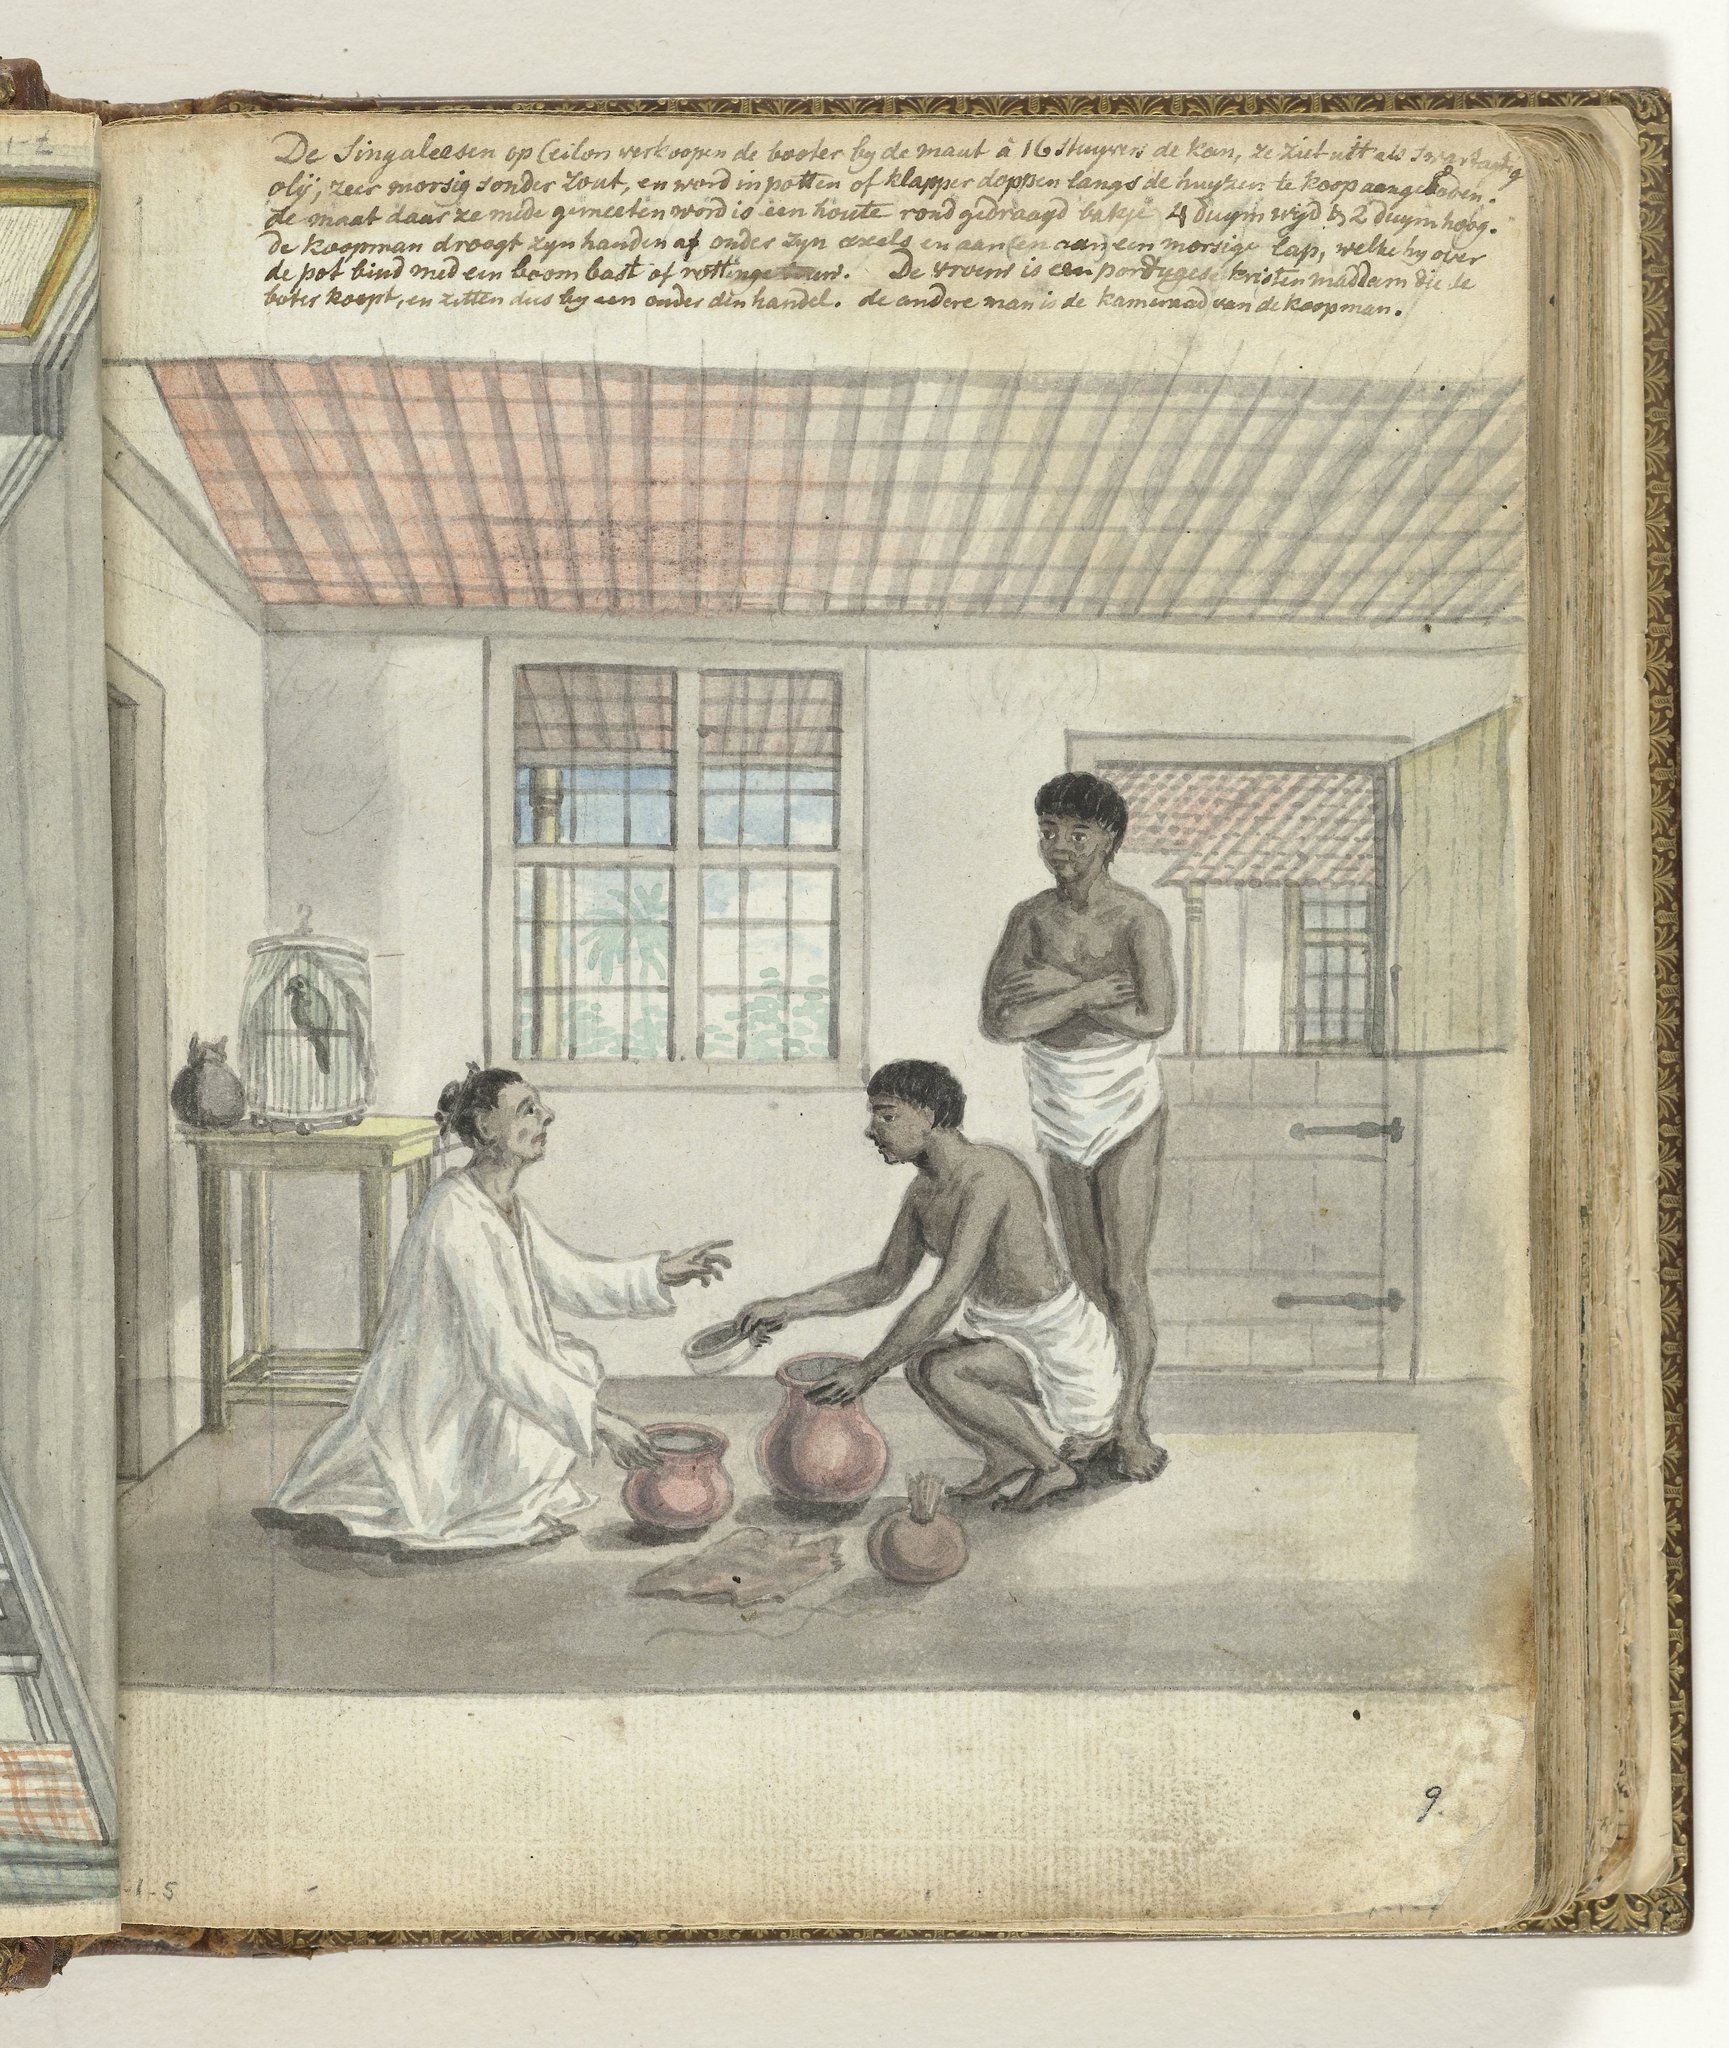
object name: drawing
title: Boterhandel op Ceylon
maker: jan brandes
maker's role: draughtsman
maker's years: 1743-1808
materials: paper, pencil, watercolor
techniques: brush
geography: sri lanka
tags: butter, persons engaged in trade and commerce, sri lanka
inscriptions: inscription: ‘De Singaleesen op Ceilon verkoopen de booter by de maat à 16 stuyvers de kan, ze ziet uit als swartagtig olij, zeer morsig sonder zout, en word in potten of klapper doppen langs de huyzen te koop aangeboden. de maat daar ze mede gemeeten word is een hout rond gedraayd bakje 4 duym wijd en 2 duym hoog. de koopman droogt zyn handen af onder zyn axels en aan (en aan) een morsige lap, welke hy over de pot bind med een boom bast of rottingetouw. De vrouw is een portugese kristen maddam die de boter koopt, en zitten dus by een onder den handel. de andere man is de kameraad van de koopman.’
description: Vrouw en boterhandelaar hurken in een vertrek. Naast de handelaar staat zijn metgezel. Met verklarend opschrift. Onderdeel uit het schetsboek van Jan Brandes, dl. 1 (1808), p. 9.